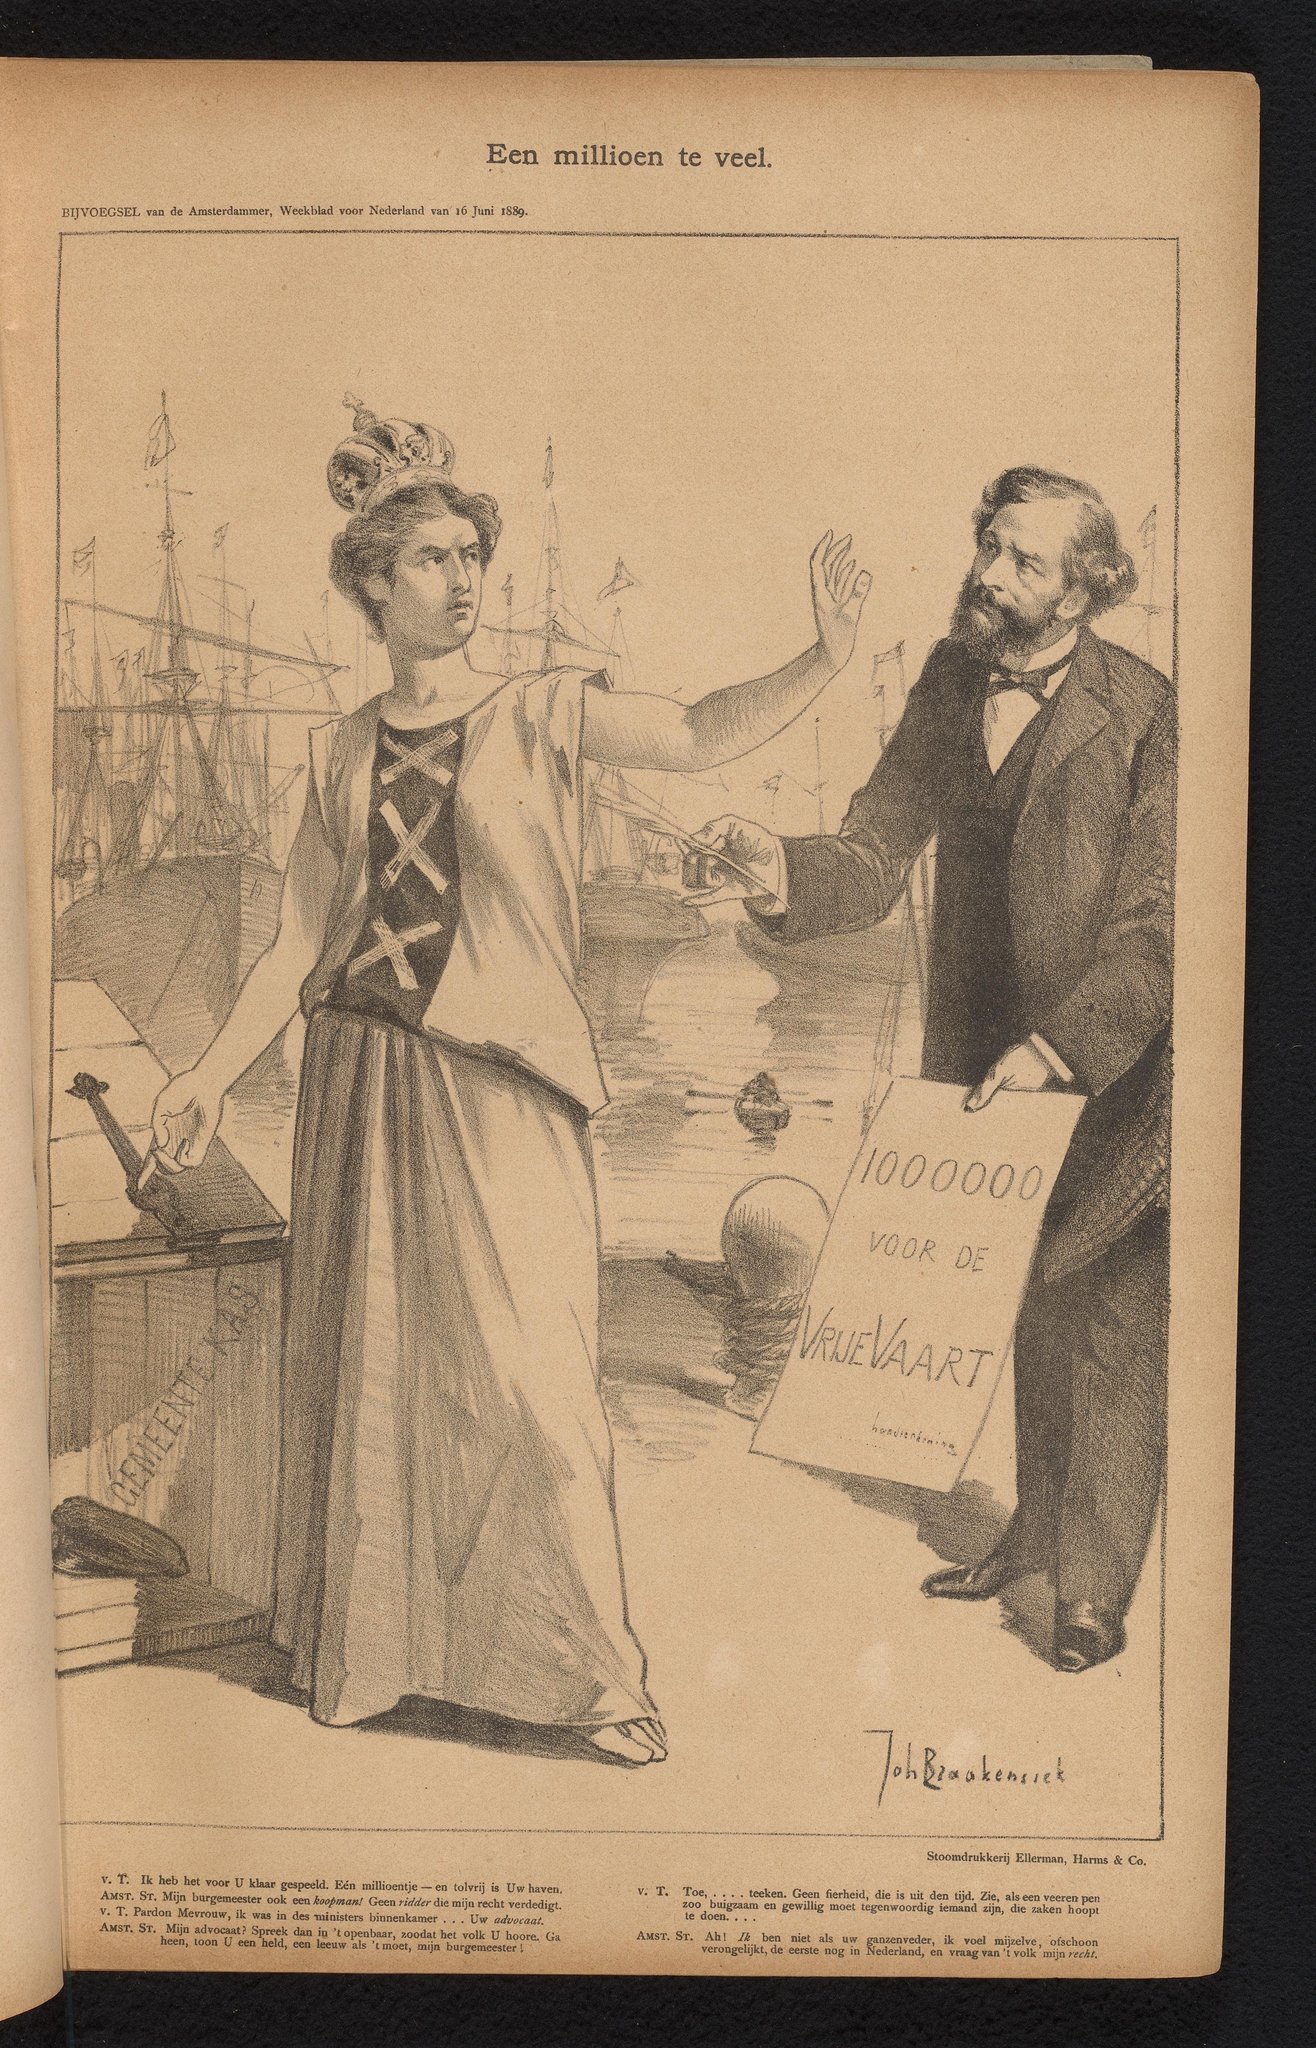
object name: cartoon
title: Een millioen te veel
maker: johan braakensiek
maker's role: draughtsman, print maker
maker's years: 1858-1940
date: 1889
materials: paper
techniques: lithograph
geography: netherlands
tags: mayor, gijsbert van tienhoven, personification of a city, town-patron(ess), mayor, burgomaster, municipal government, political caricatures and satires, amsterdam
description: De burgemeester van Amsterdam Gijsbert van Tienhoven vraagt de Amsterdamse stadsmaagd om financiering voor de 'vrije vaart'. Zij wijst hem echter op de lege gemeenteklas.